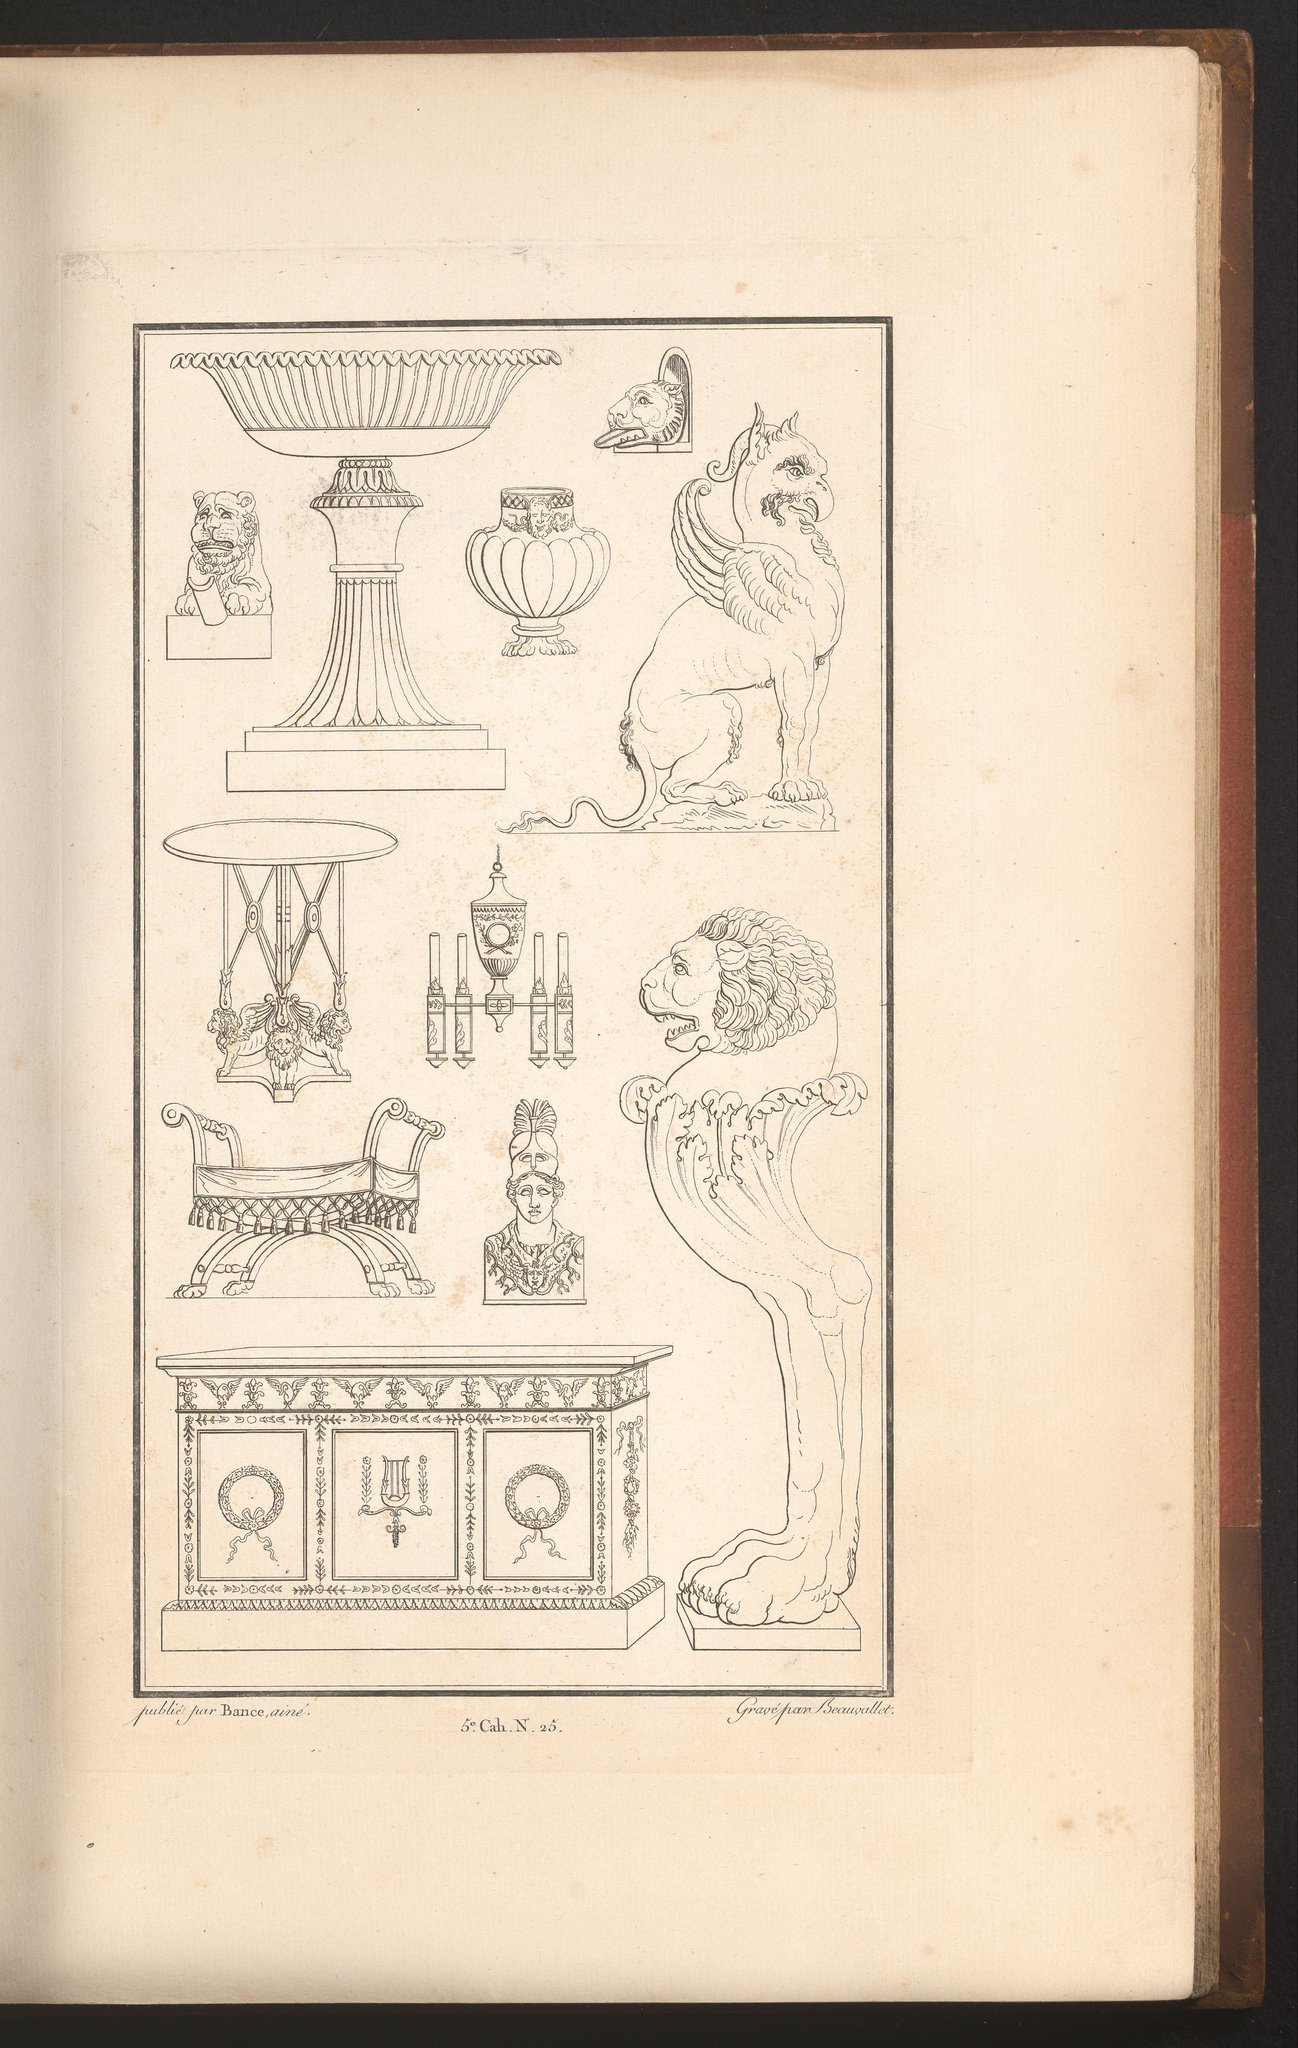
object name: ornament print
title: Diverse ornamenten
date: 1820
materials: paper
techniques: etching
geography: paris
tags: decorative furniture, ornaments ~ art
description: Ornamentprent met diverse meubels en andere objecten. Onderdeel (5e. Cah. N. 25) van het prentalbum met twee series van in totaal 138 ornamentprenten door Beauvallet en Normand, 'Fragmens d'Ornemens dans le Style Antique'.